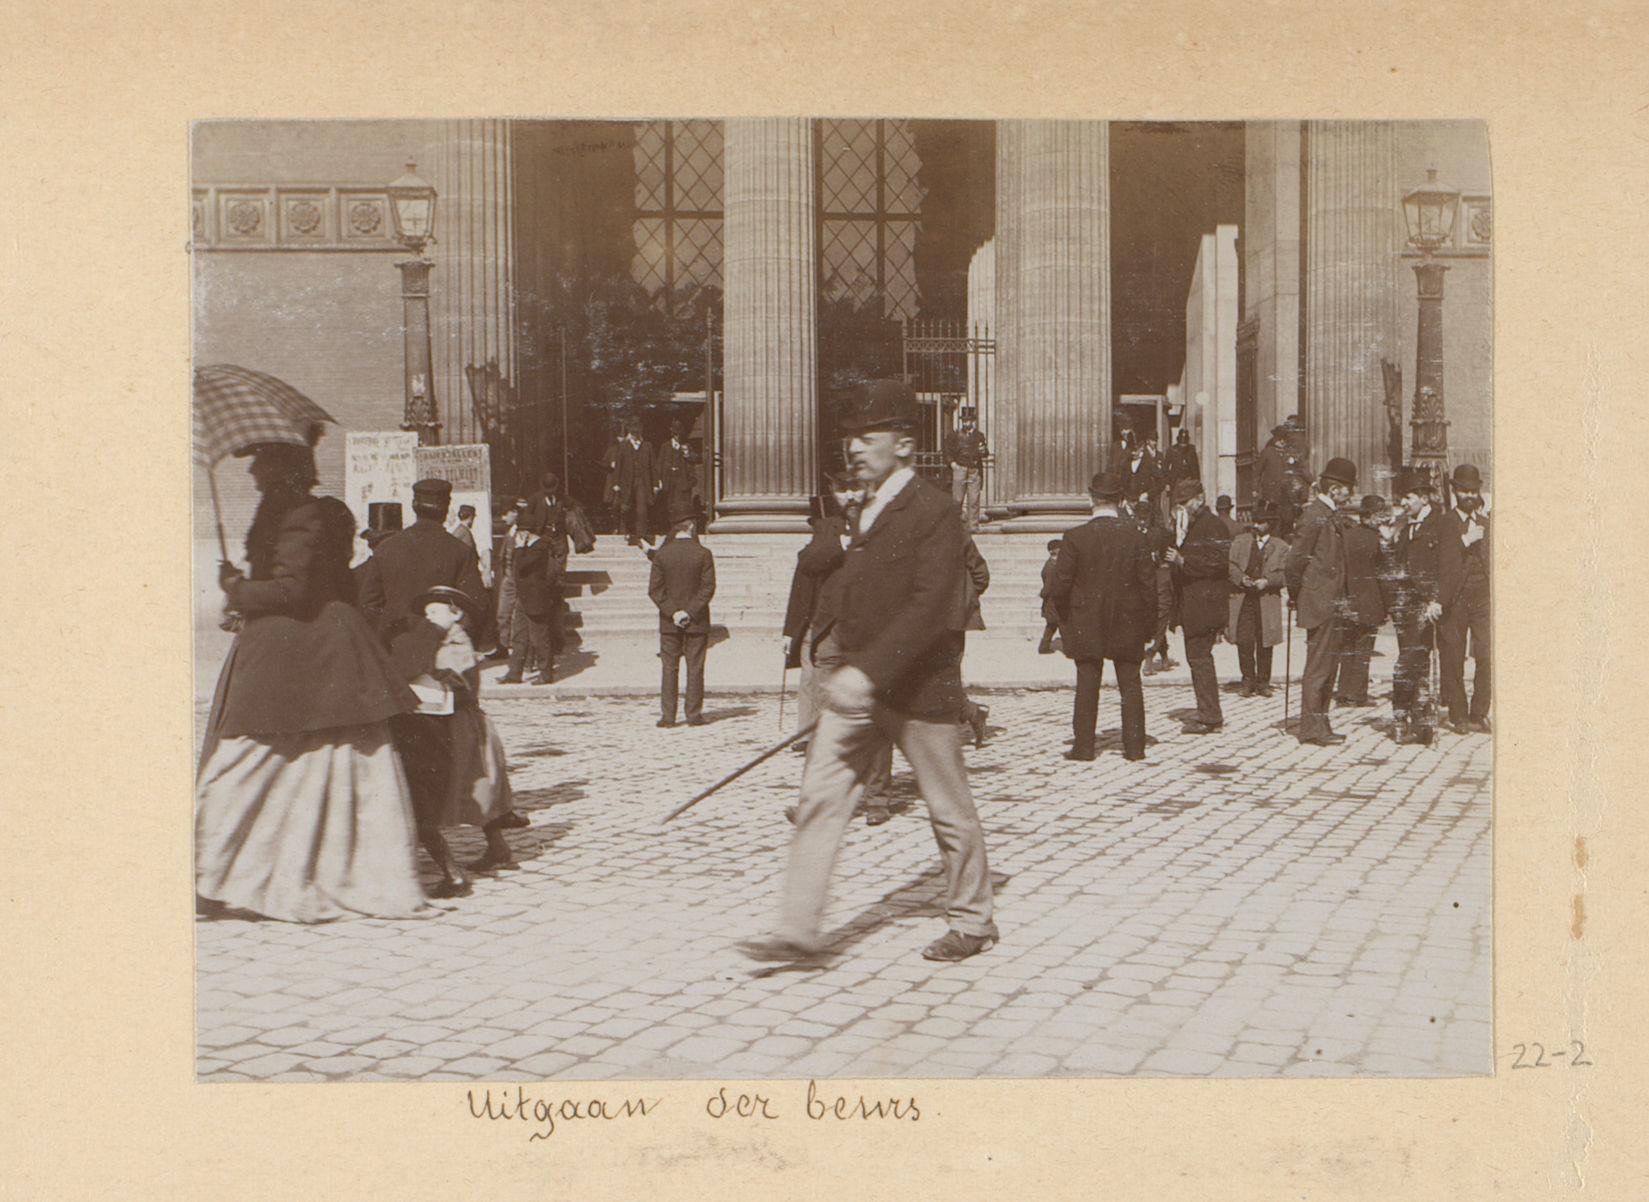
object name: album leaf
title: Bankiers of handelaars voor de Beurs van Zocher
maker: hendrik herman van den berg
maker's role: amateurfotograaf, jurist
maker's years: 1875-1944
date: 1890-1894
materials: paper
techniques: collodion silver print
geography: amsterdam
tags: exchange, bourse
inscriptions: annotation: ‘Uitgaan der beurs’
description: Foto 2 op albumblad 22 uit album "Amsterdam 1890-1894".